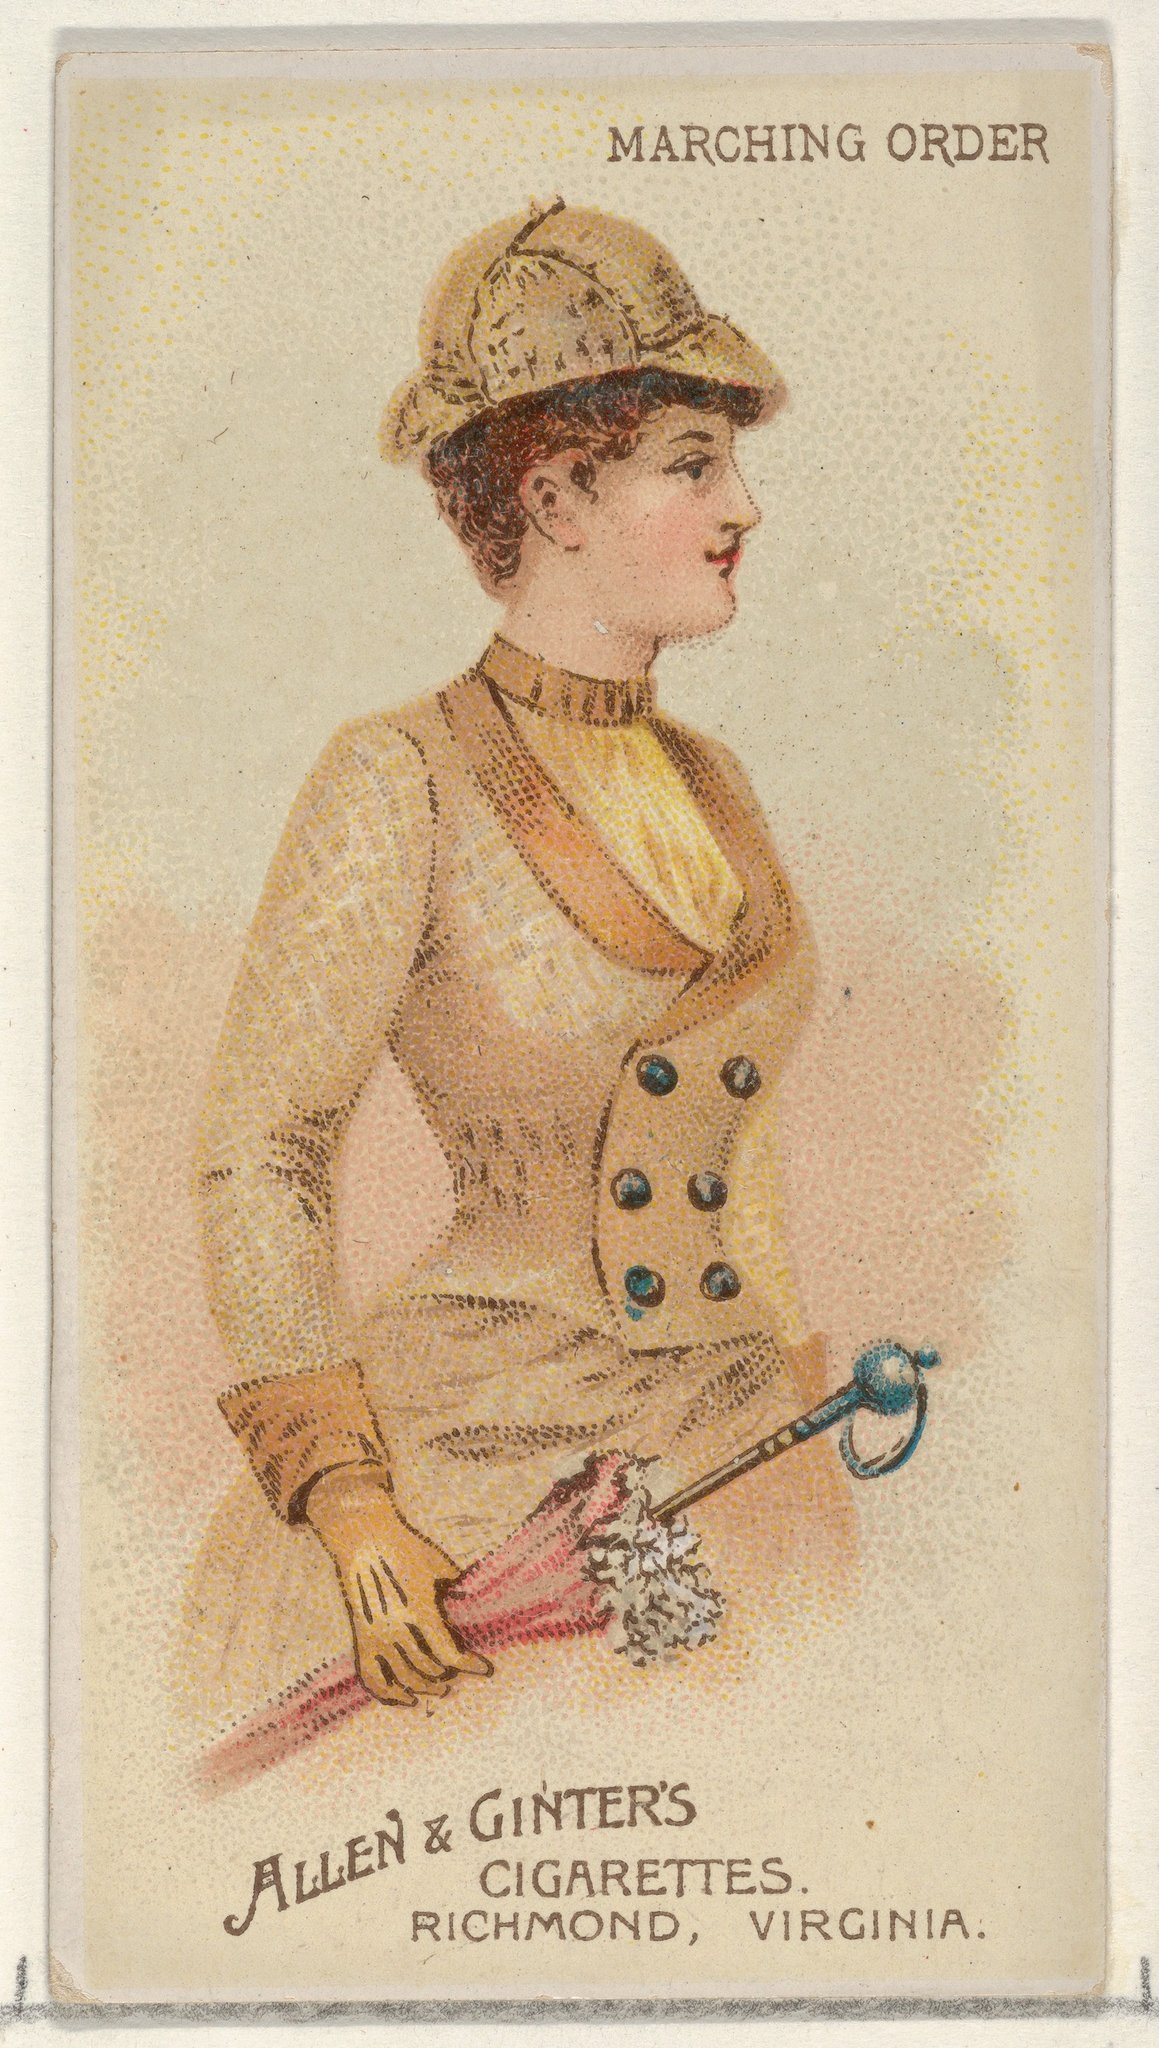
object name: print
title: Marching Order, from the Parasol Drills series (N18) for Allen & Ginter Cigarettes Brands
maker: allen & ginter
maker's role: publisher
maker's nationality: american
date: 1888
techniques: color lithograph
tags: women